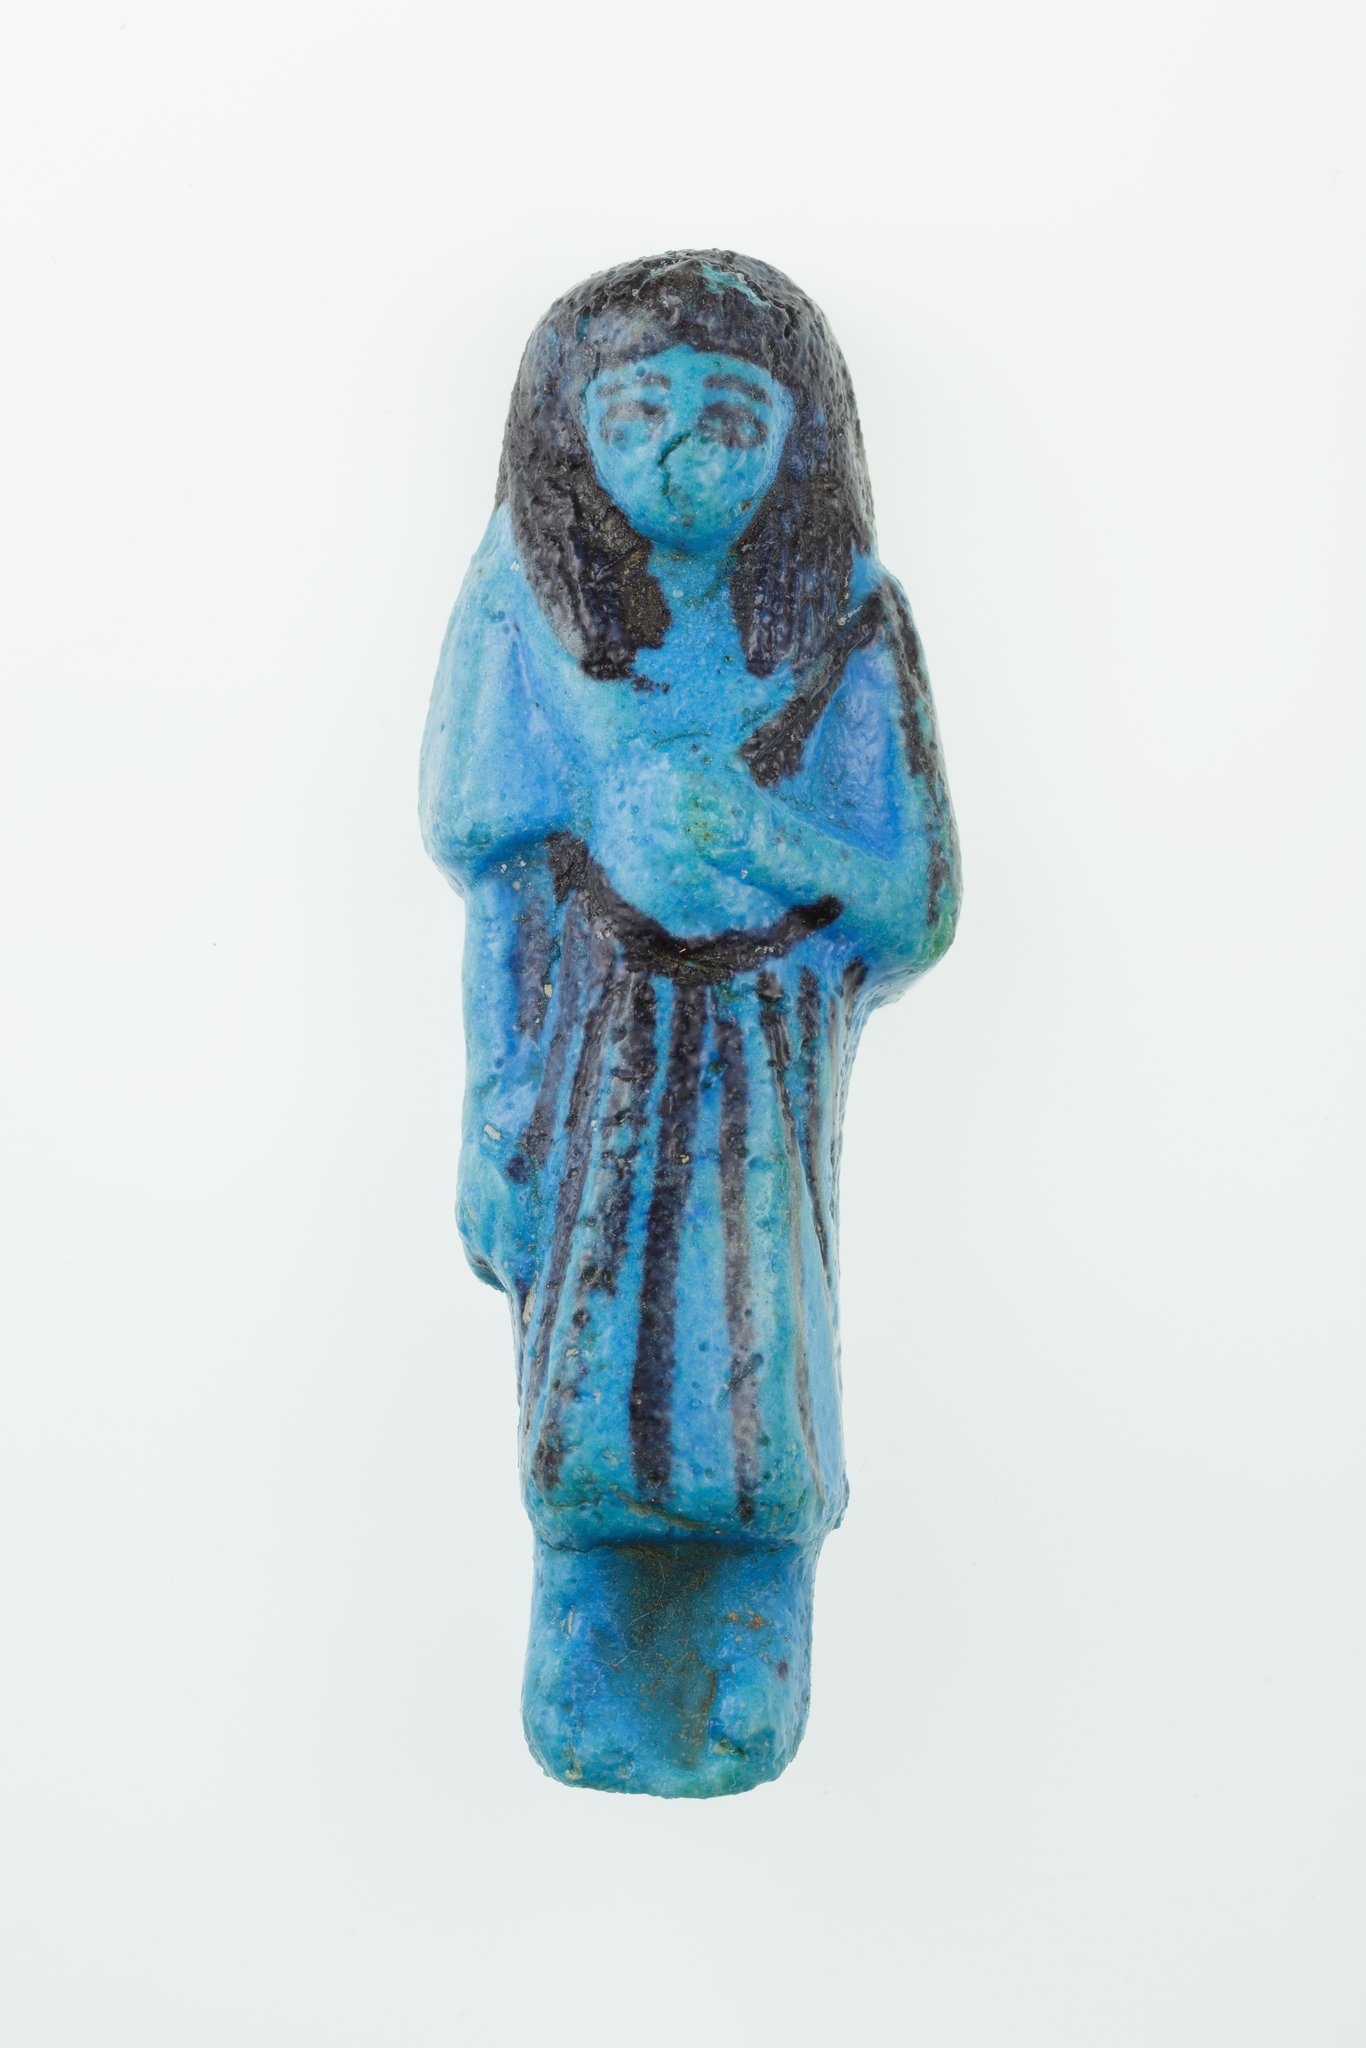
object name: shabti, nauny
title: Overseer Shabti of Nauny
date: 1050 BCE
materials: faience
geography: egypt